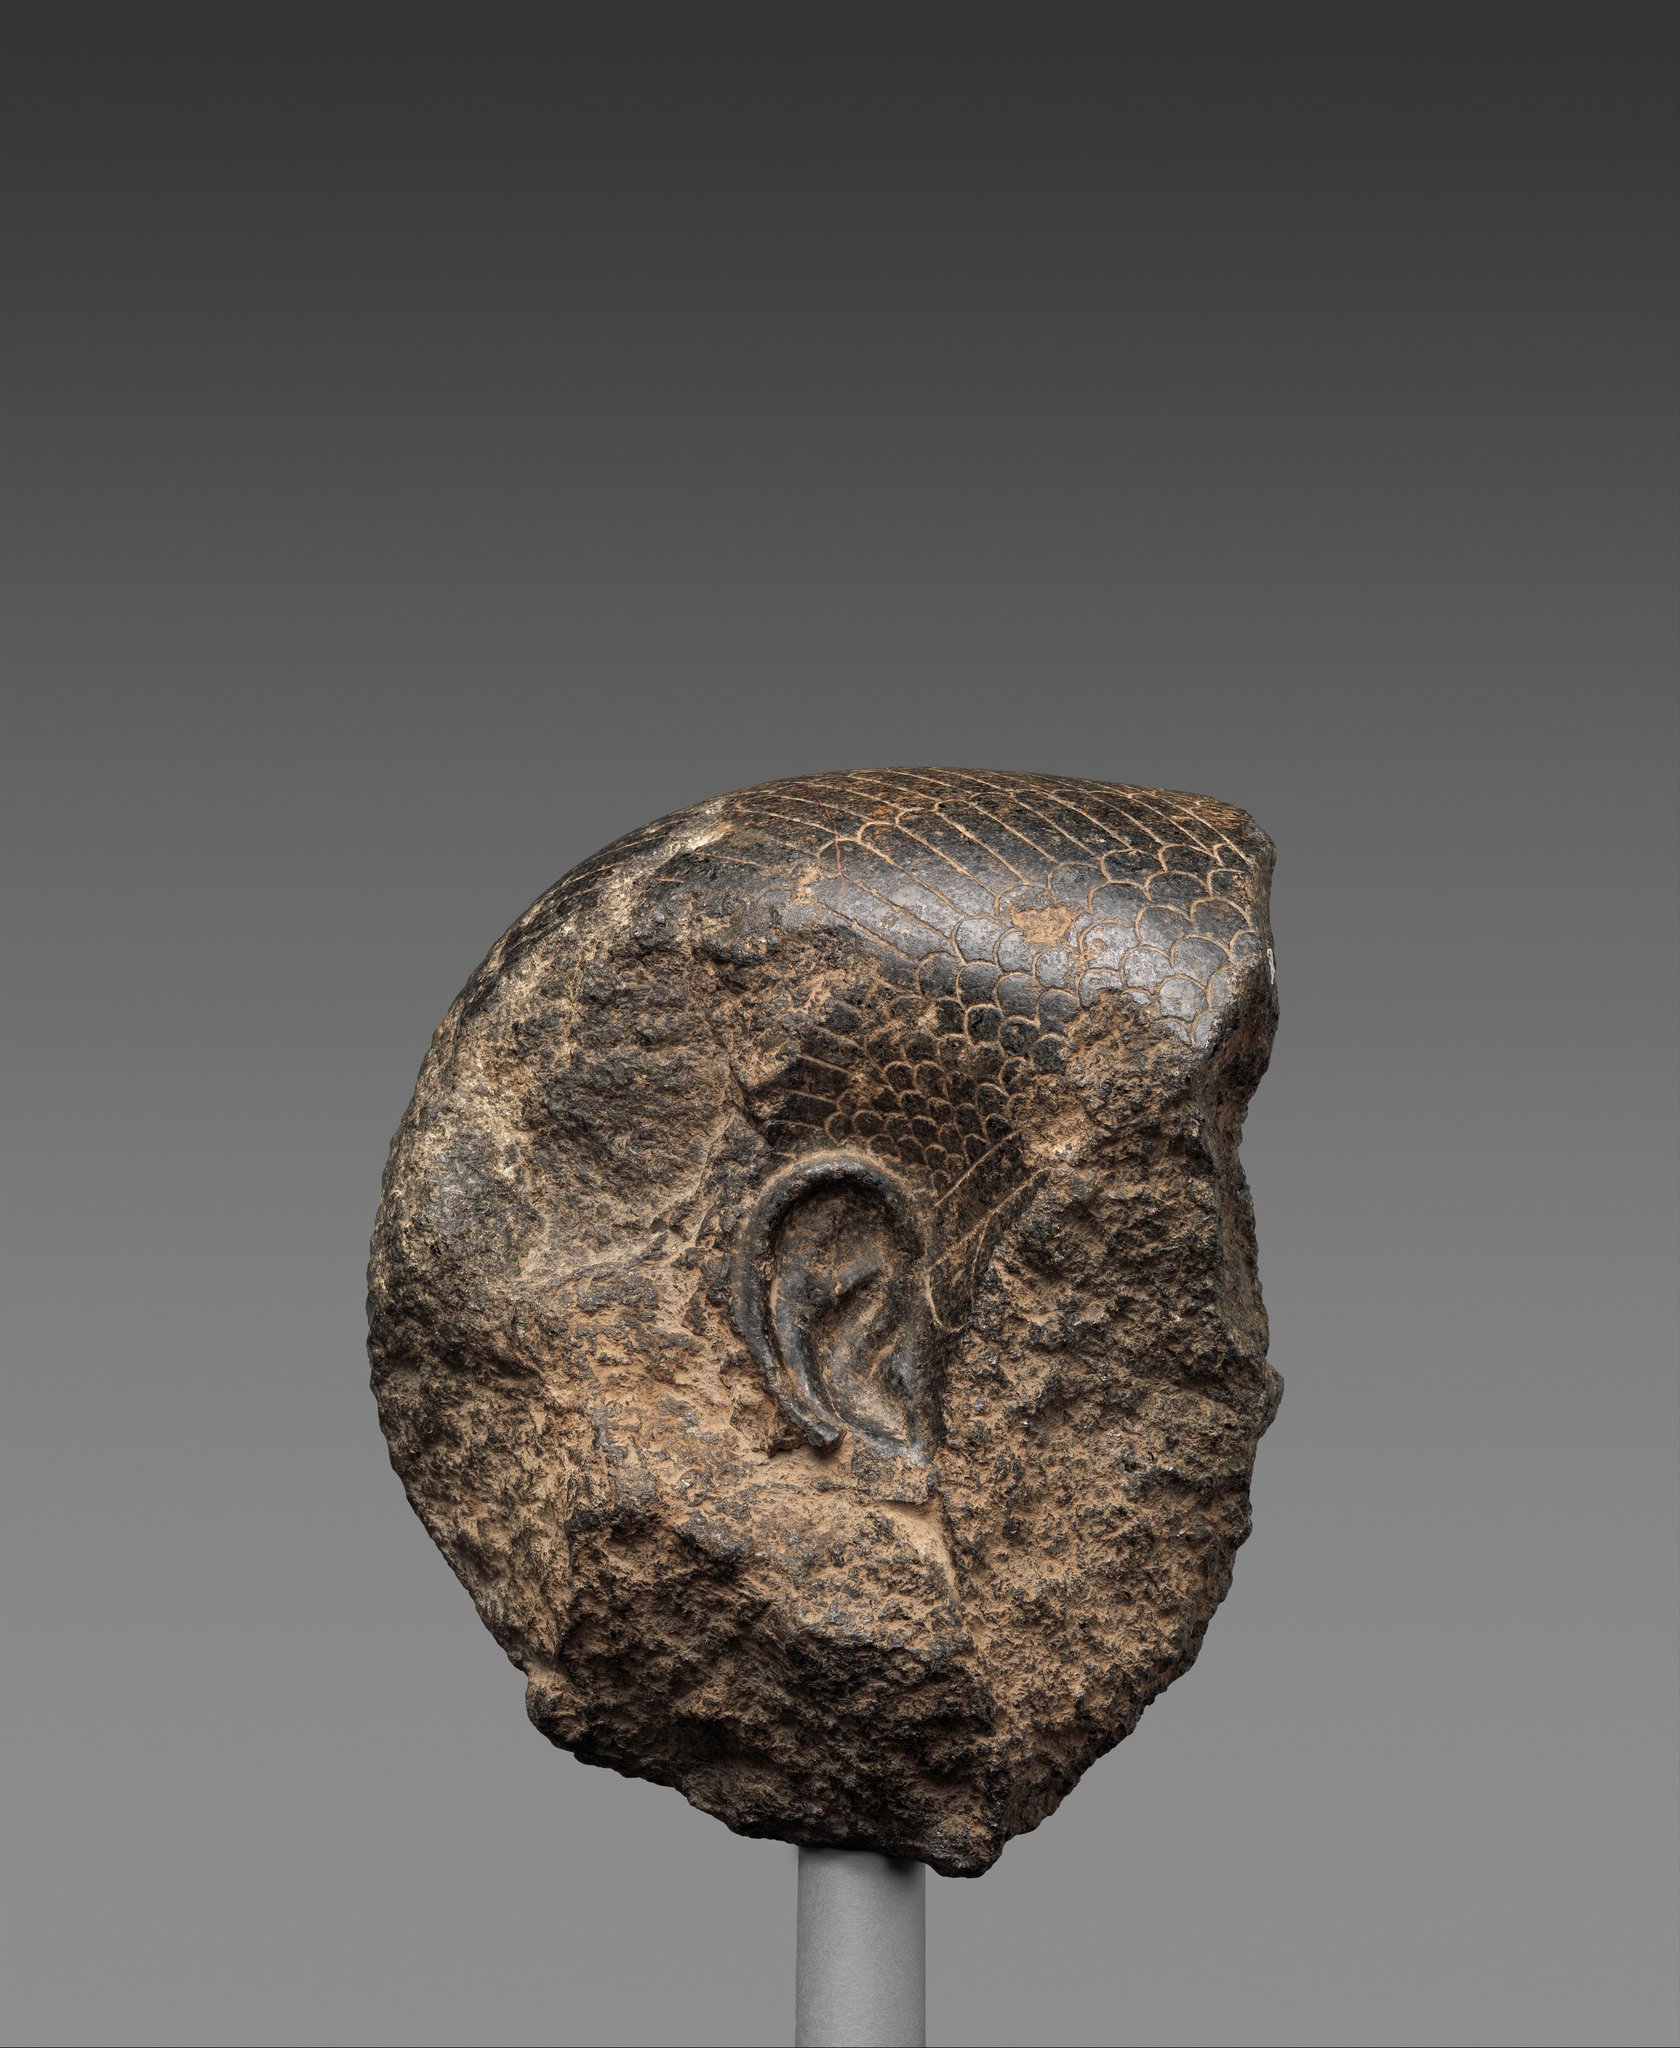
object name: head, woman, fragment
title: Fragment from the Head of a Queen's Statue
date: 1981-1802 BCE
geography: egypt